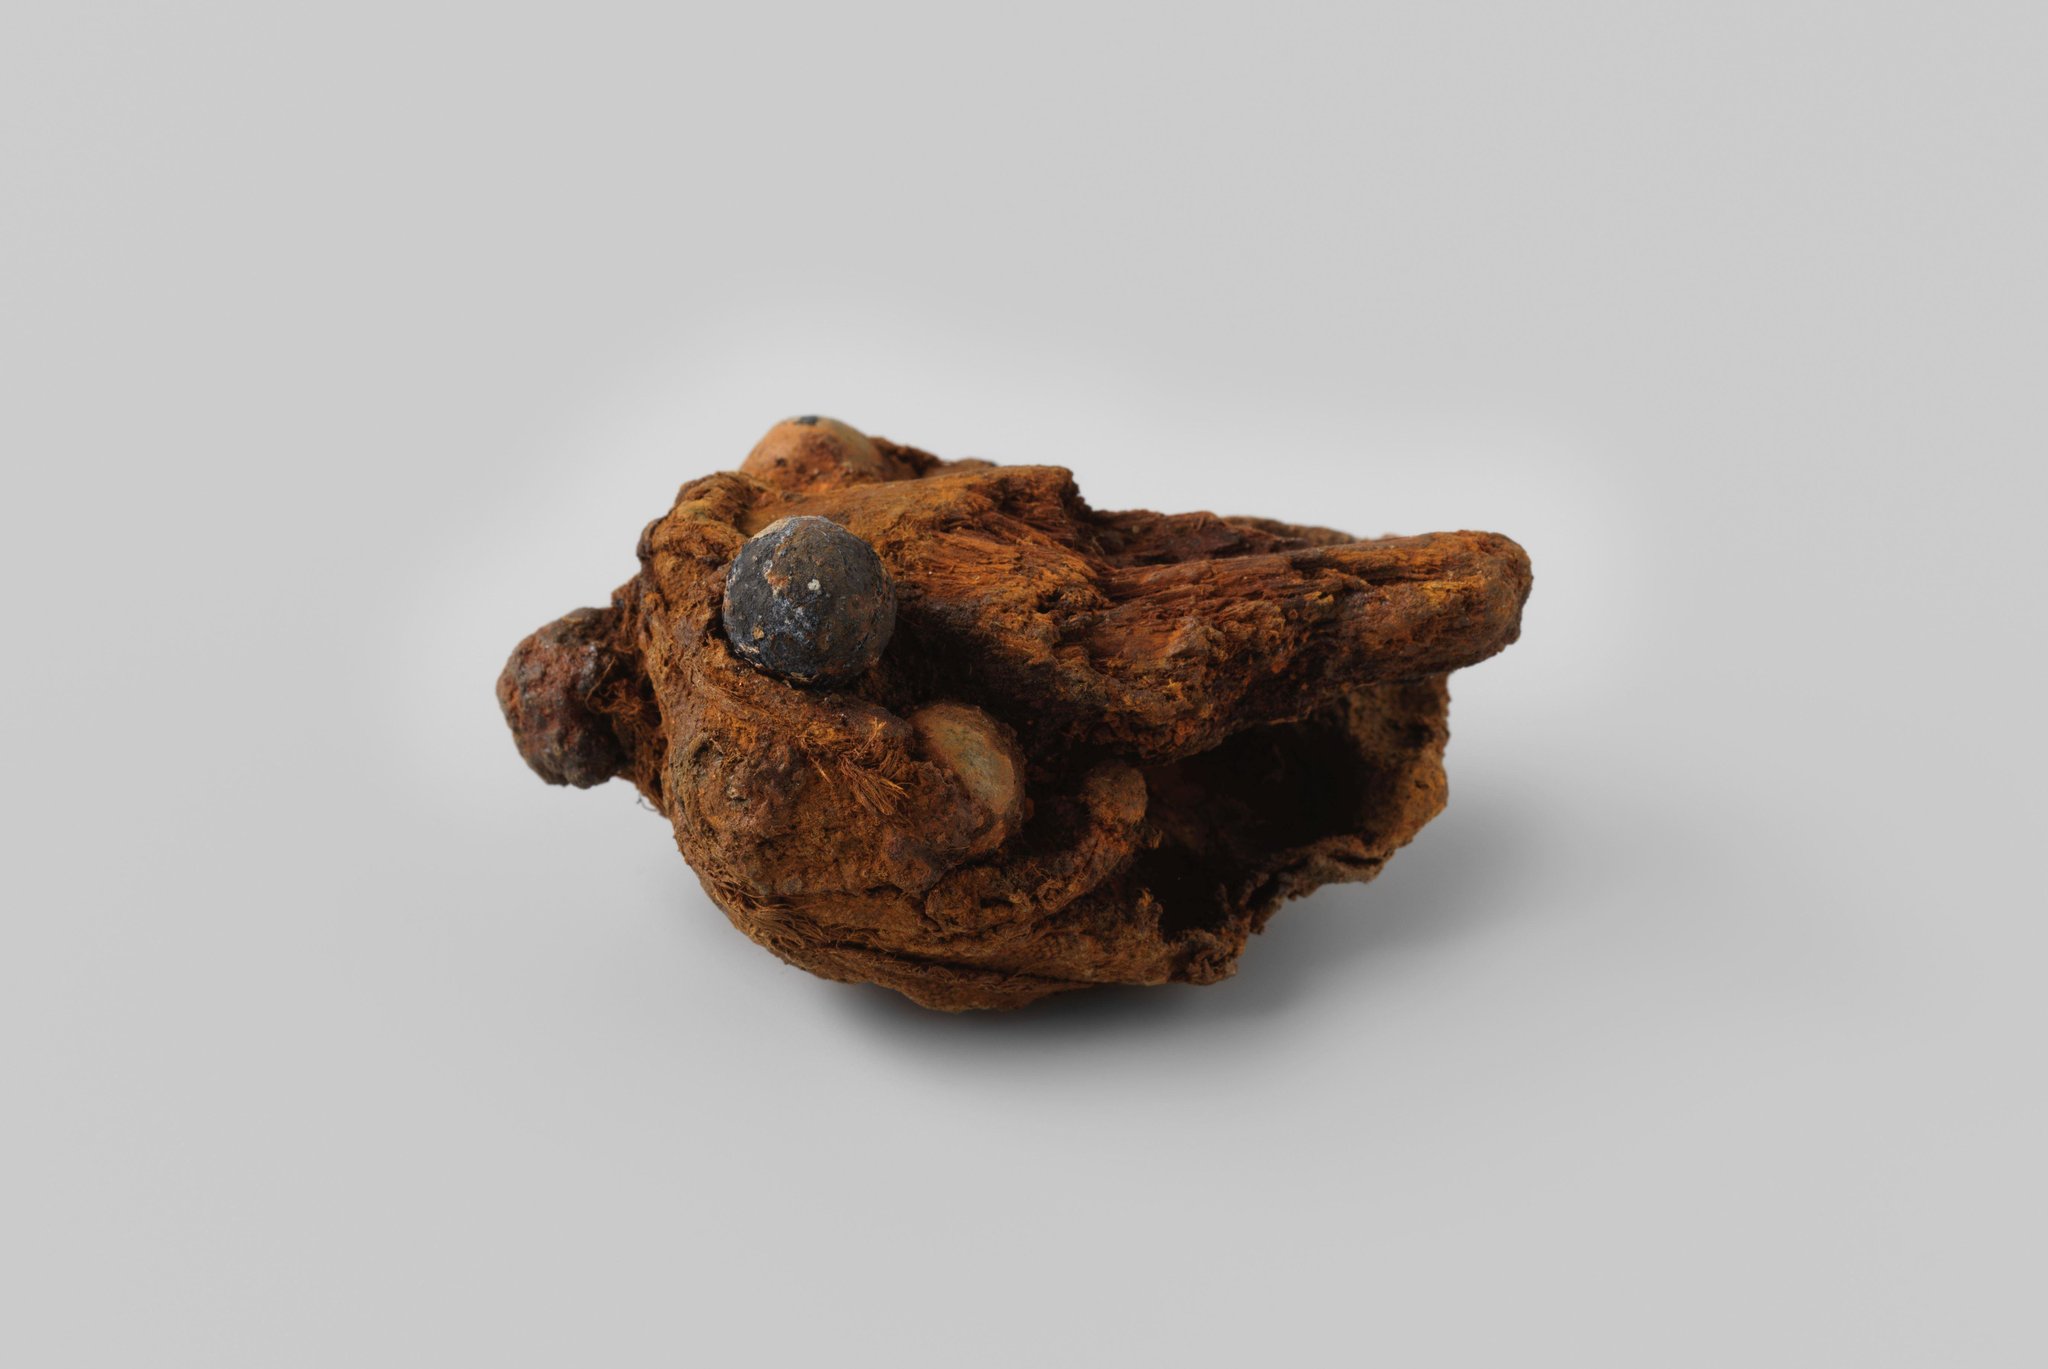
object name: bullet ammunition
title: Shot or grape shot from the wreck of the Dutch East Indiaman Hollandia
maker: Anonymous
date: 1700-1743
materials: fiber, lead, wood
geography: netherlands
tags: verenigde oostindische compagnie, hollandia (schip), annet